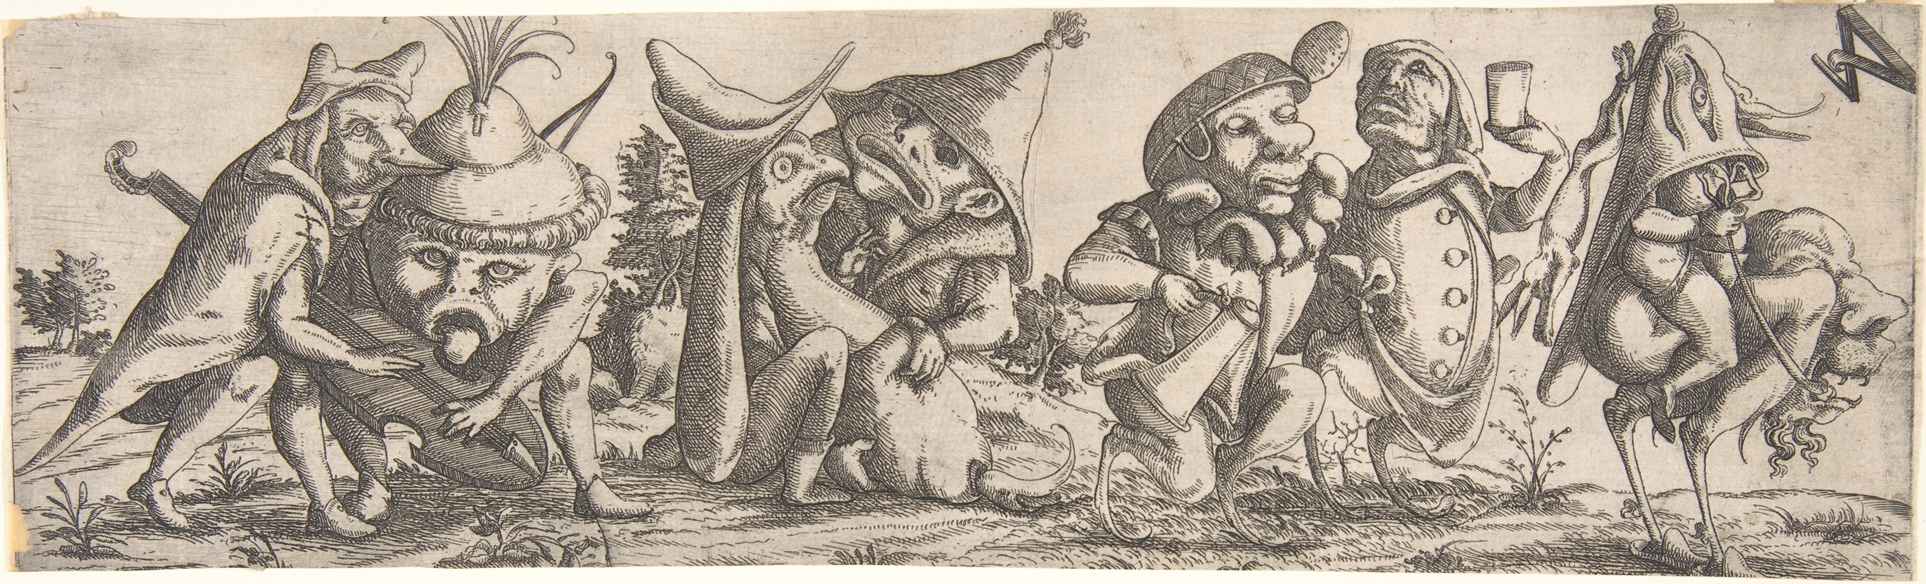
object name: print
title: Procession of Monstrous Figures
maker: wendel dietterlin, the younger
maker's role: artist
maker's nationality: german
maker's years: 1614-1669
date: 1615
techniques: etching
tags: musical instruments,monsters